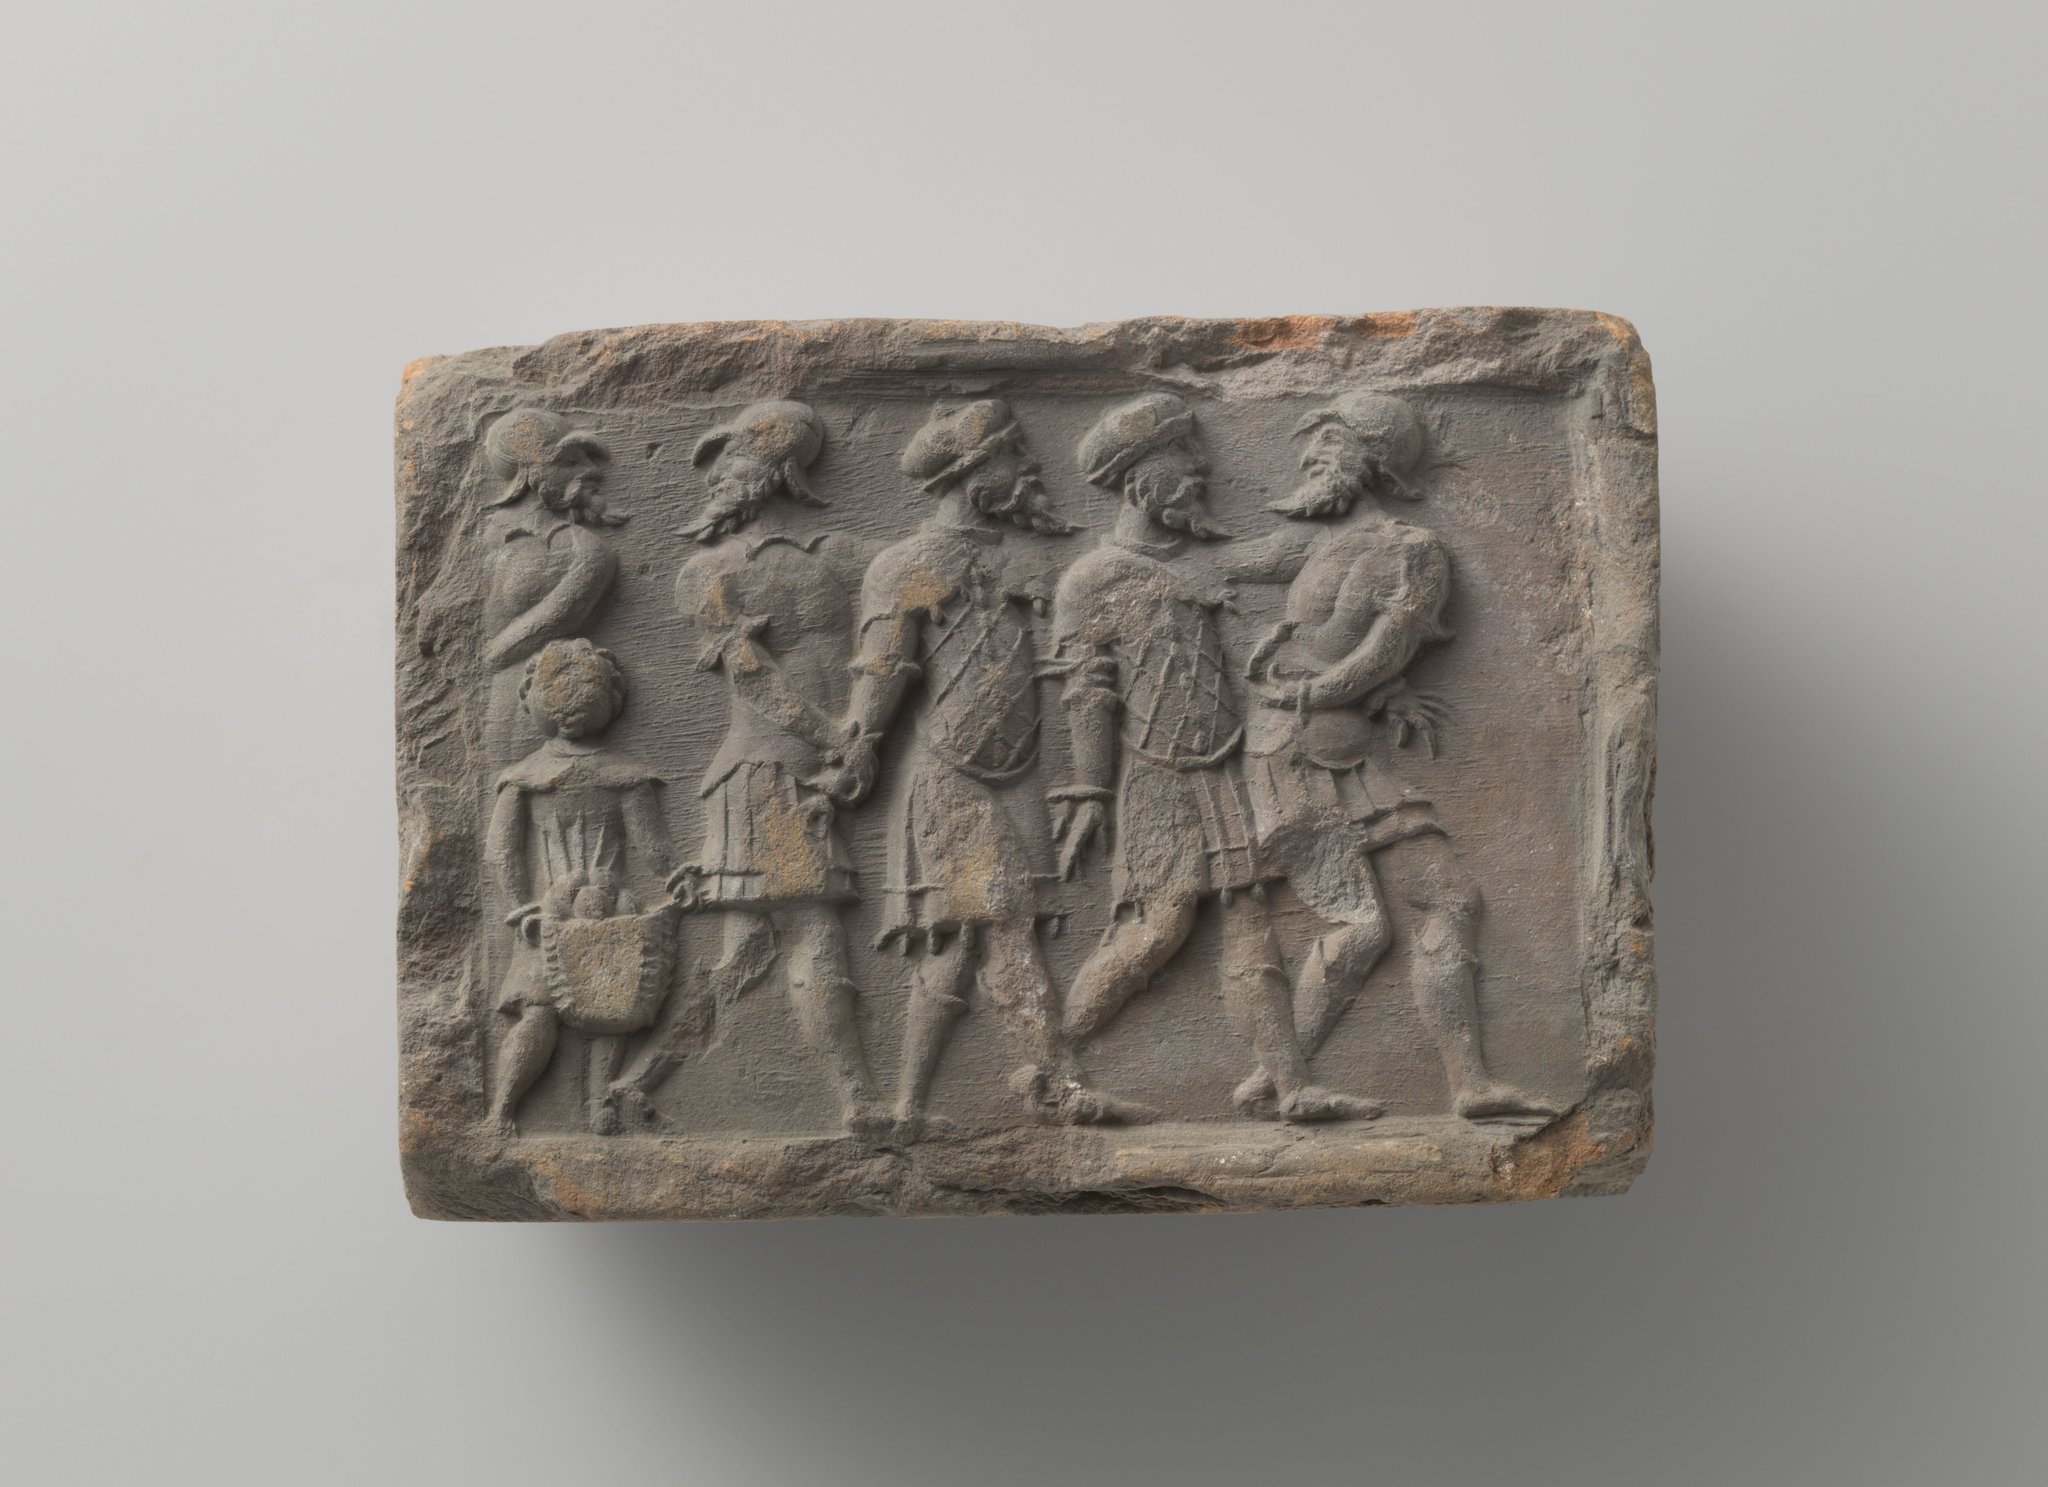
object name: hearthstone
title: Haardsteen met afbeelding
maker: Anonymous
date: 1400-1950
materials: earthenware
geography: southern netherlands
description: Haardsteen. "De boeven uitgeleid om gestenigd te worden".